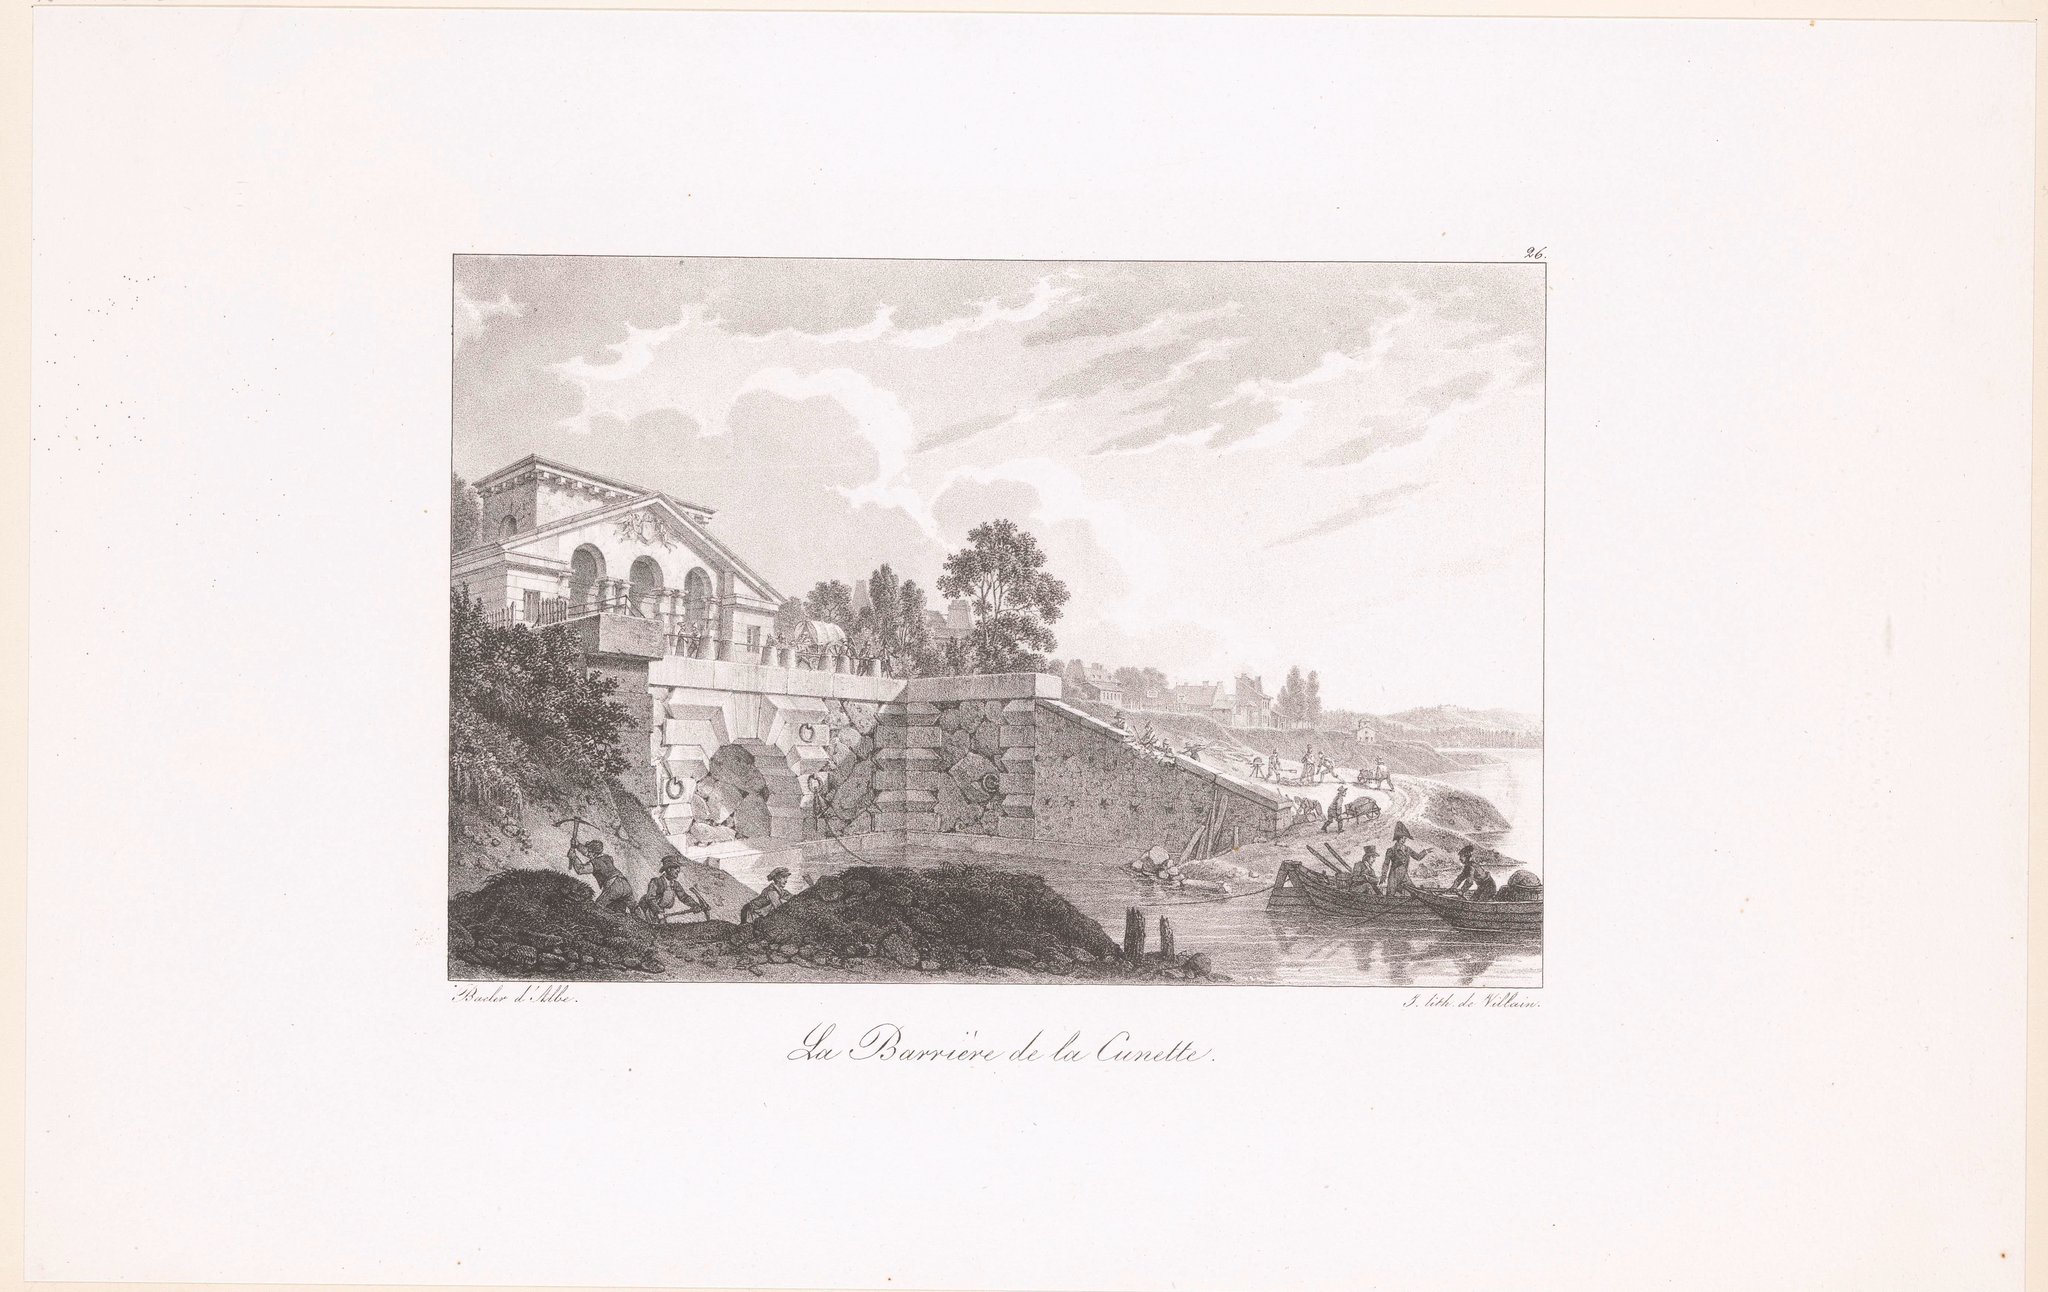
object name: print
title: La Barrière de la Cunette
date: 1822-1824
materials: paper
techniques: lithograph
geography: paris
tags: river bank, toll gate, quay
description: De Barrière de la Cunette was een van de 55 doorgangen in de Muur van de Belastingpachters in Parijs. Bij het accijnshuis naast de tolpoort werd belasting geïnd op goederen die de stad in- en uitgingen.